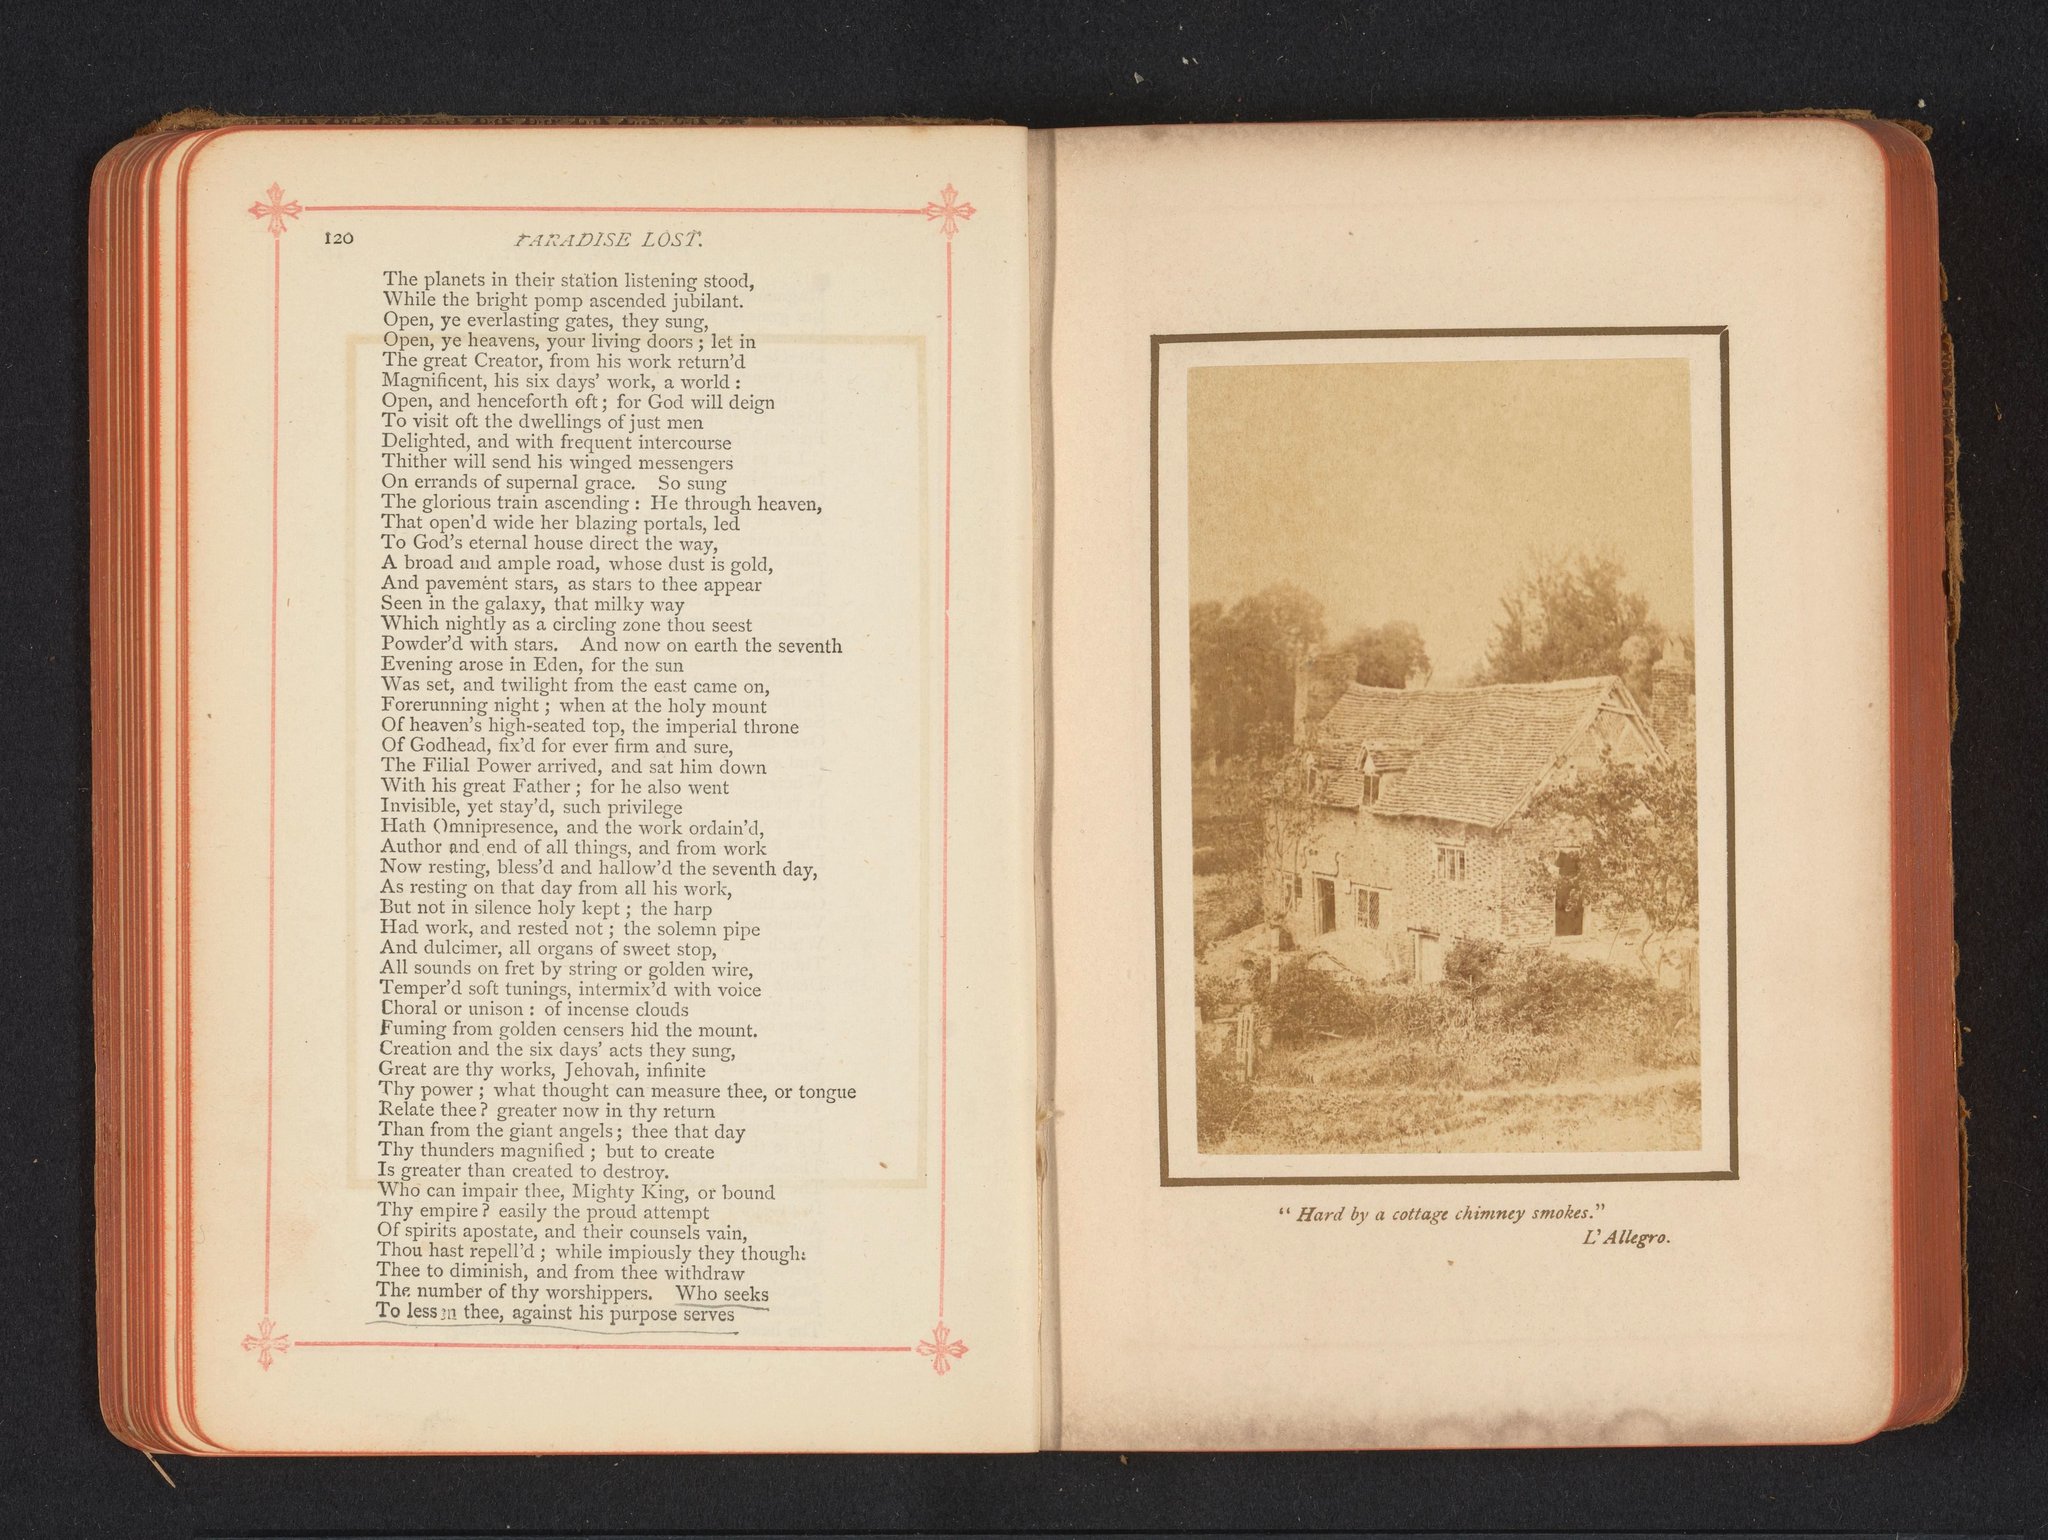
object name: photograph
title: Gezicht op een landhuis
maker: deswall vaughan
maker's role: fotograaf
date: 1875-1885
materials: photographic support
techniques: albumen print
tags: cottage, façade (of house or building)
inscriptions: inscription: ‘" Hard by a cottage chimney smokes." L'allegro’